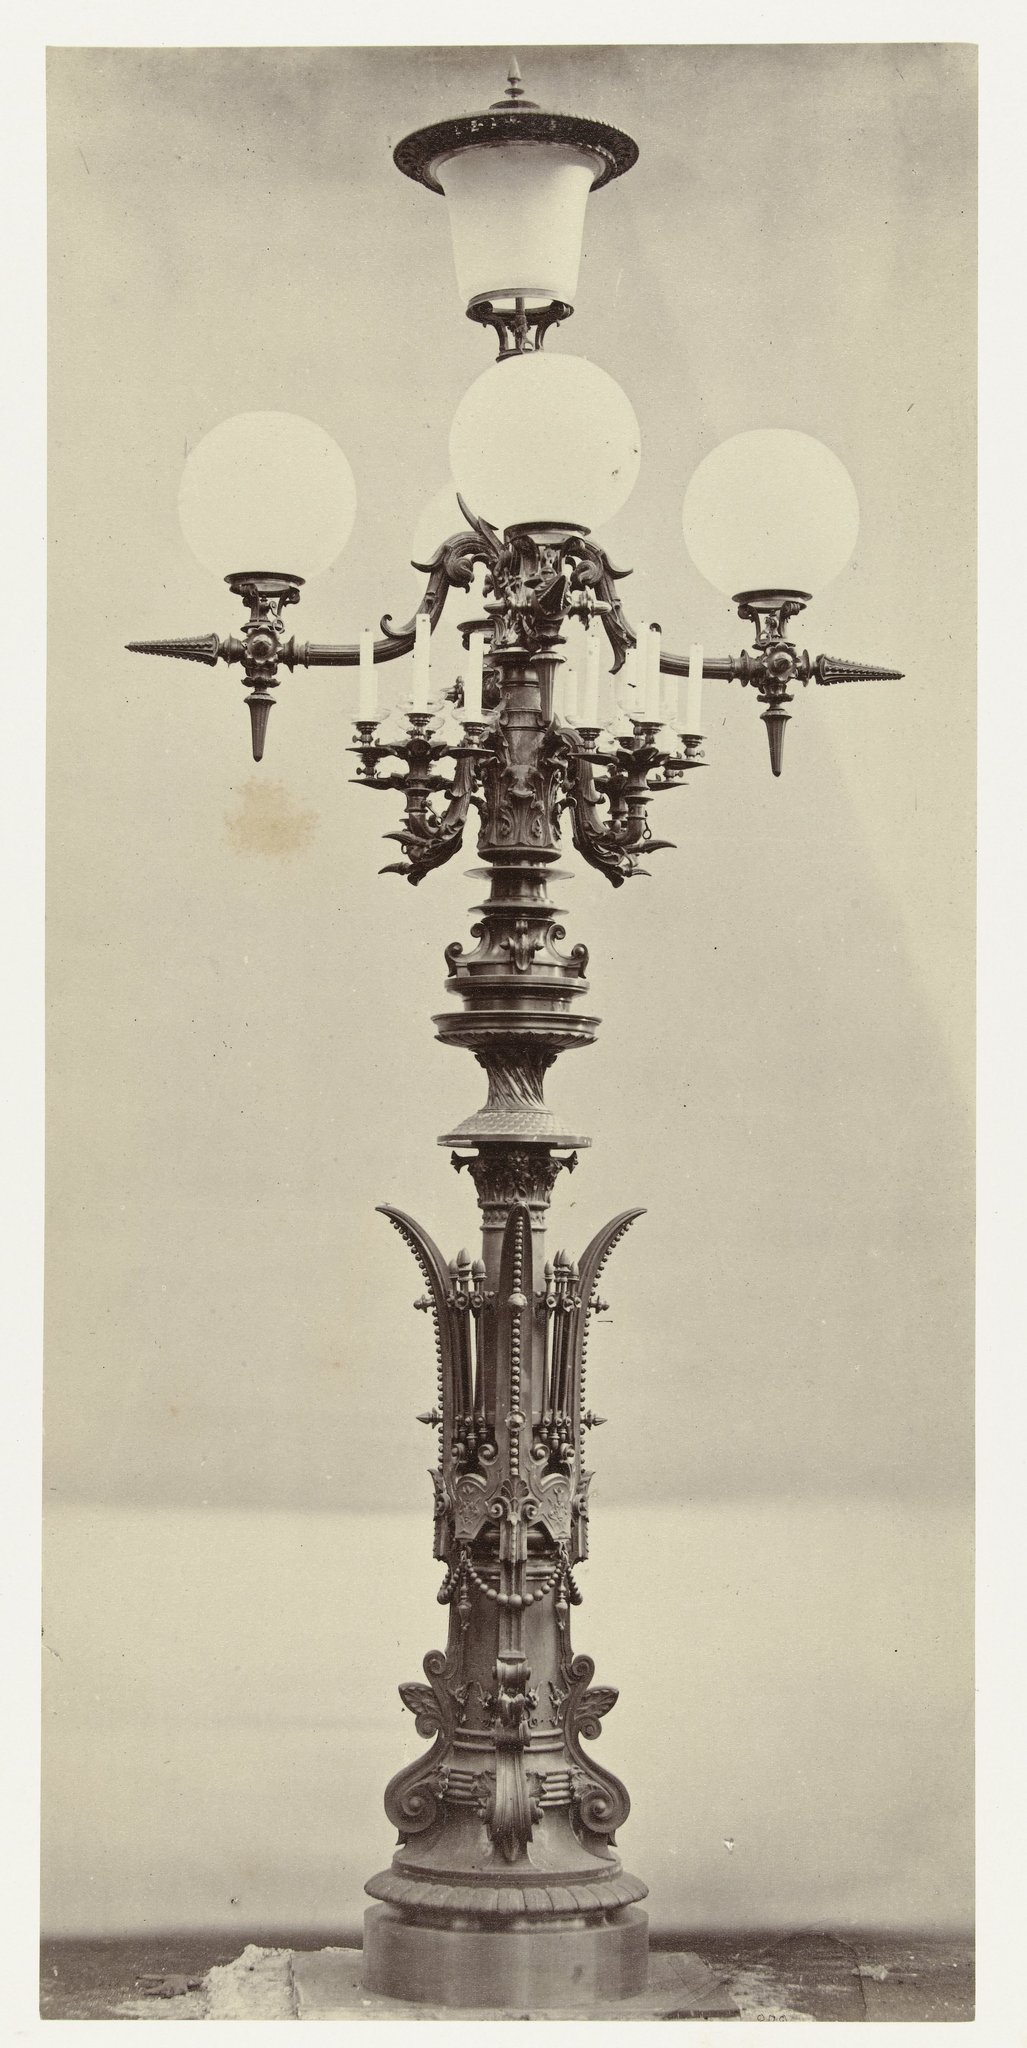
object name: photograph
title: 12. Le nouvel Opéra de Paris. Bronzes.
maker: louis-emile durandelle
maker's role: fotograaf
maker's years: 1839-1917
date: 1878-1881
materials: photographic support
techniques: albumen print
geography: paris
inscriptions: number: ‘12’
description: bij boek in Bibliotheek RMA, Zie Frizot, pp. 217-223, vgl G. Vicaire, Manuel de l'amateur de livres du XIXe siècle, vol. 3, column 870.